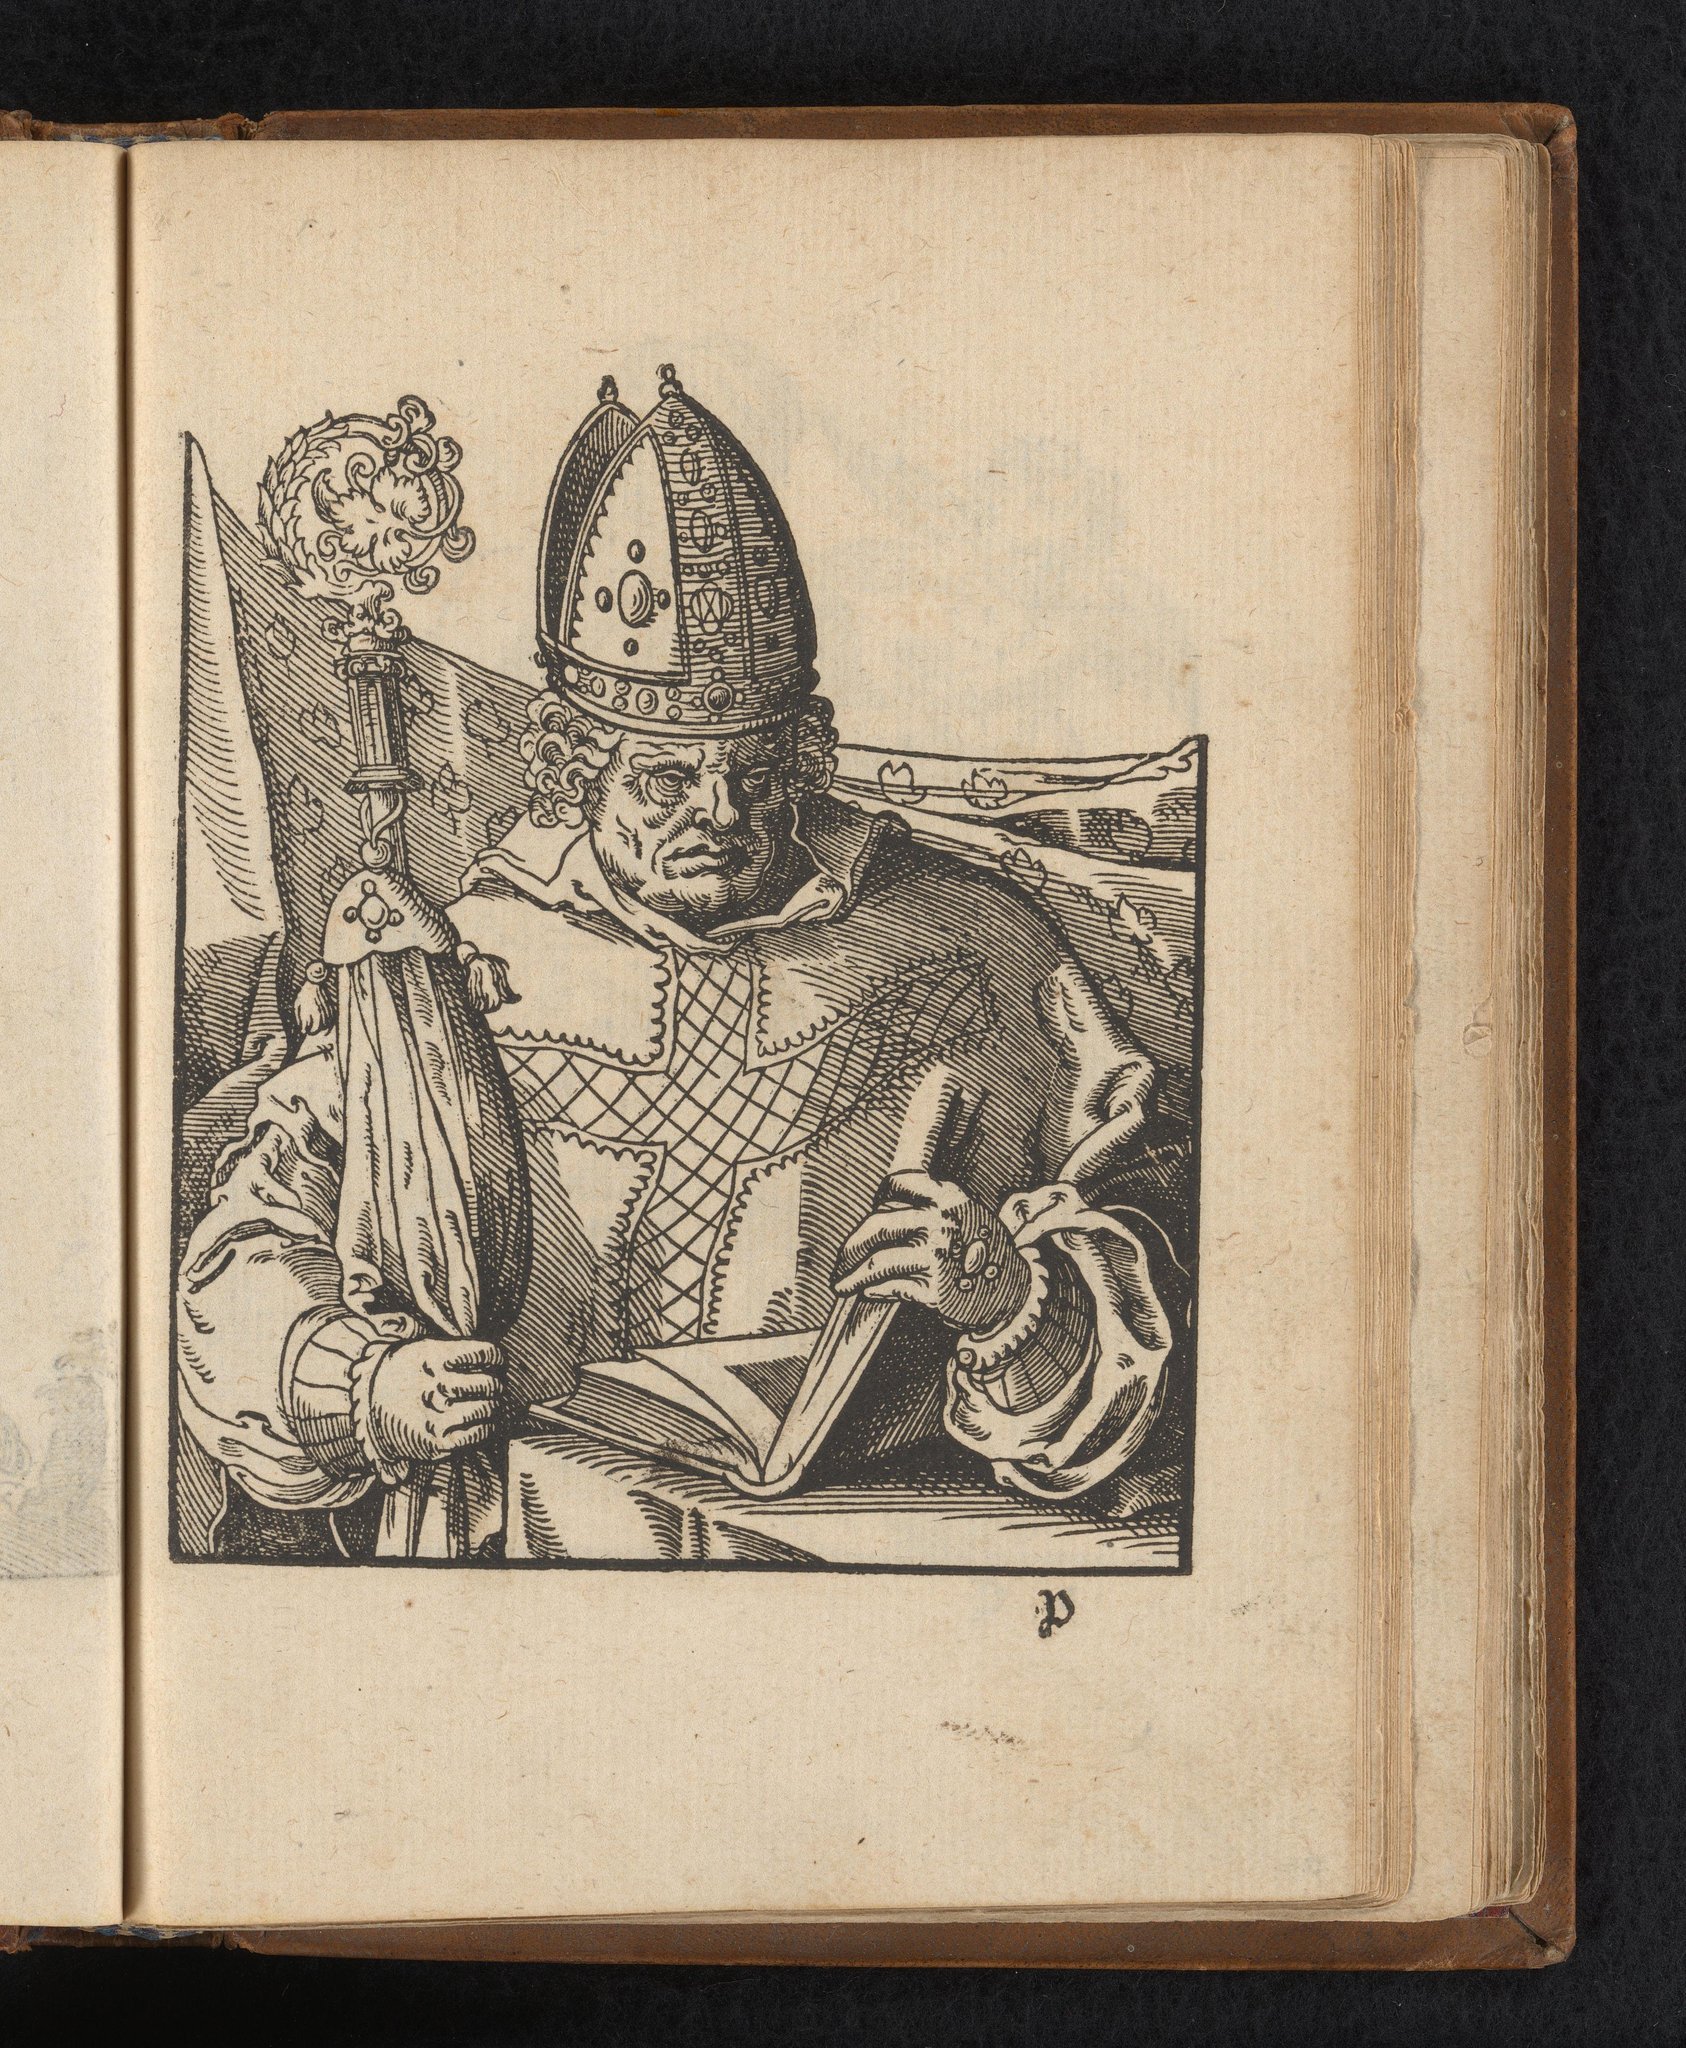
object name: print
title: Bisschop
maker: Anonymous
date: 1578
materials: paper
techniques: woodcut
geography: nuremberg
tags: archbishop, bishop, etc. (roman catholic), reading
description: Bisschop, halffiguur, lezend in een boek. Onderdeel van het modelboek Enchiridion artis pingendi, fingendi & sculpendi met 108 figuren bedoeld voor beginnende schilders, beeldhouwers en prentmakers.